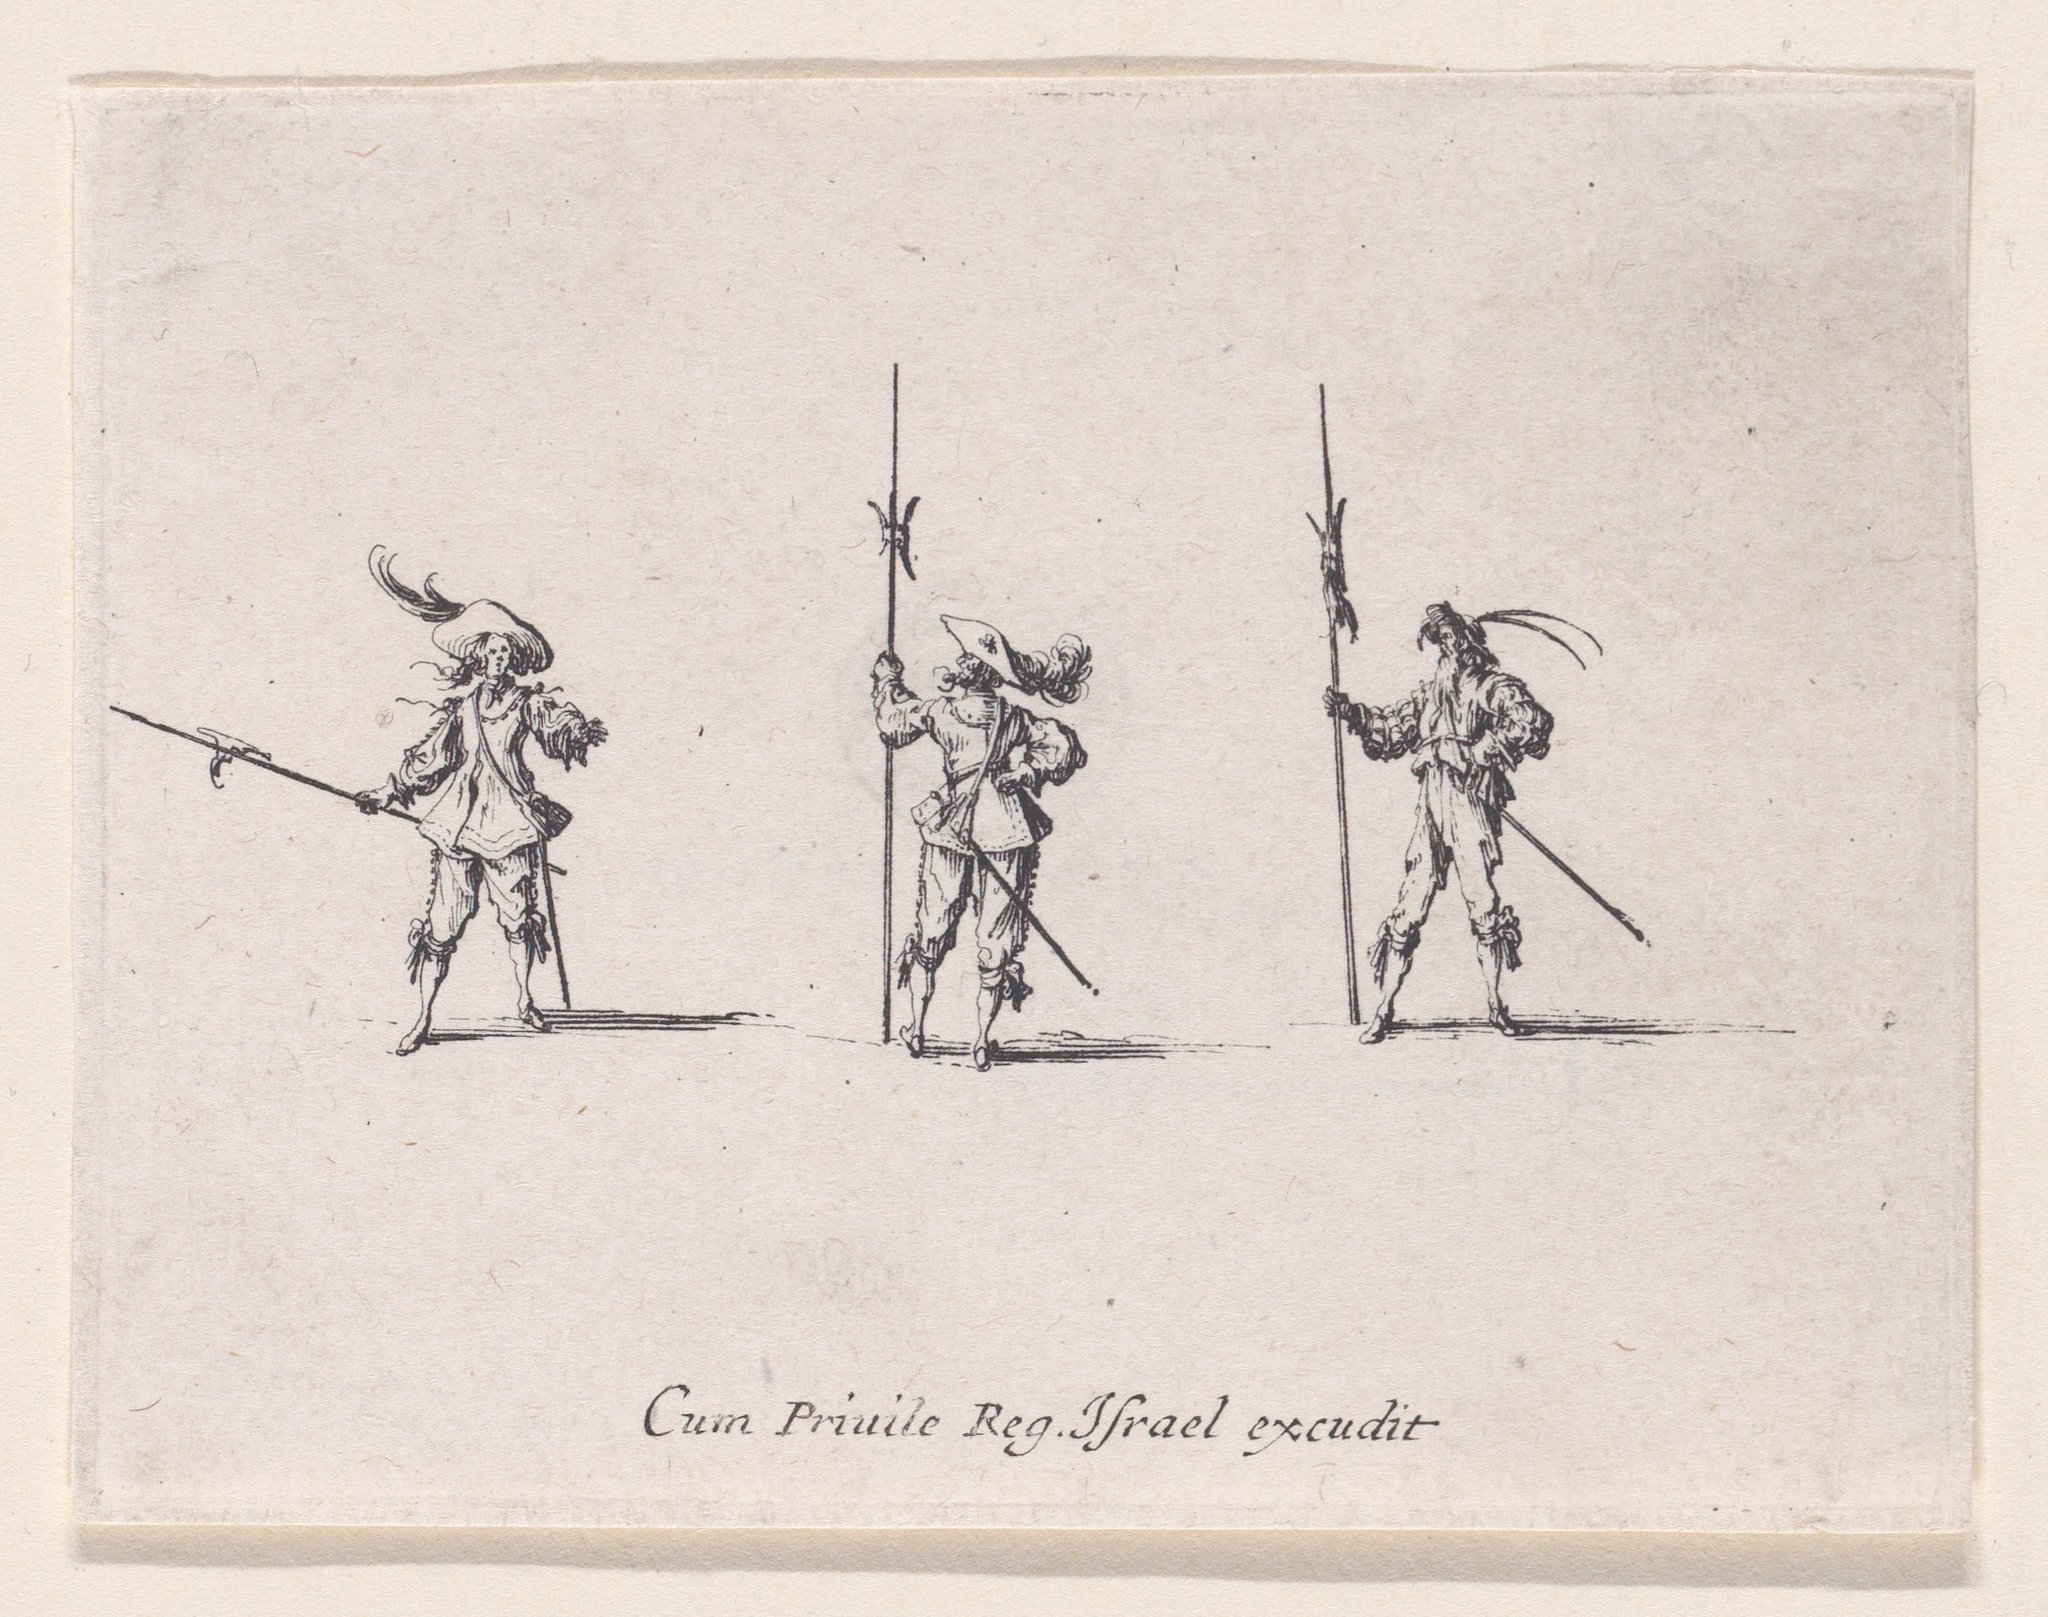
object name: print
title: L'Exercice de la Hallebarde (Drill with Halberds), from "Les Exercices Militaires" (The Military Exercises)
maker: jacques callot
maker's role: artist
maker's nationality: french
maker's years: 1592-1635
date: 1635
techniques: etching